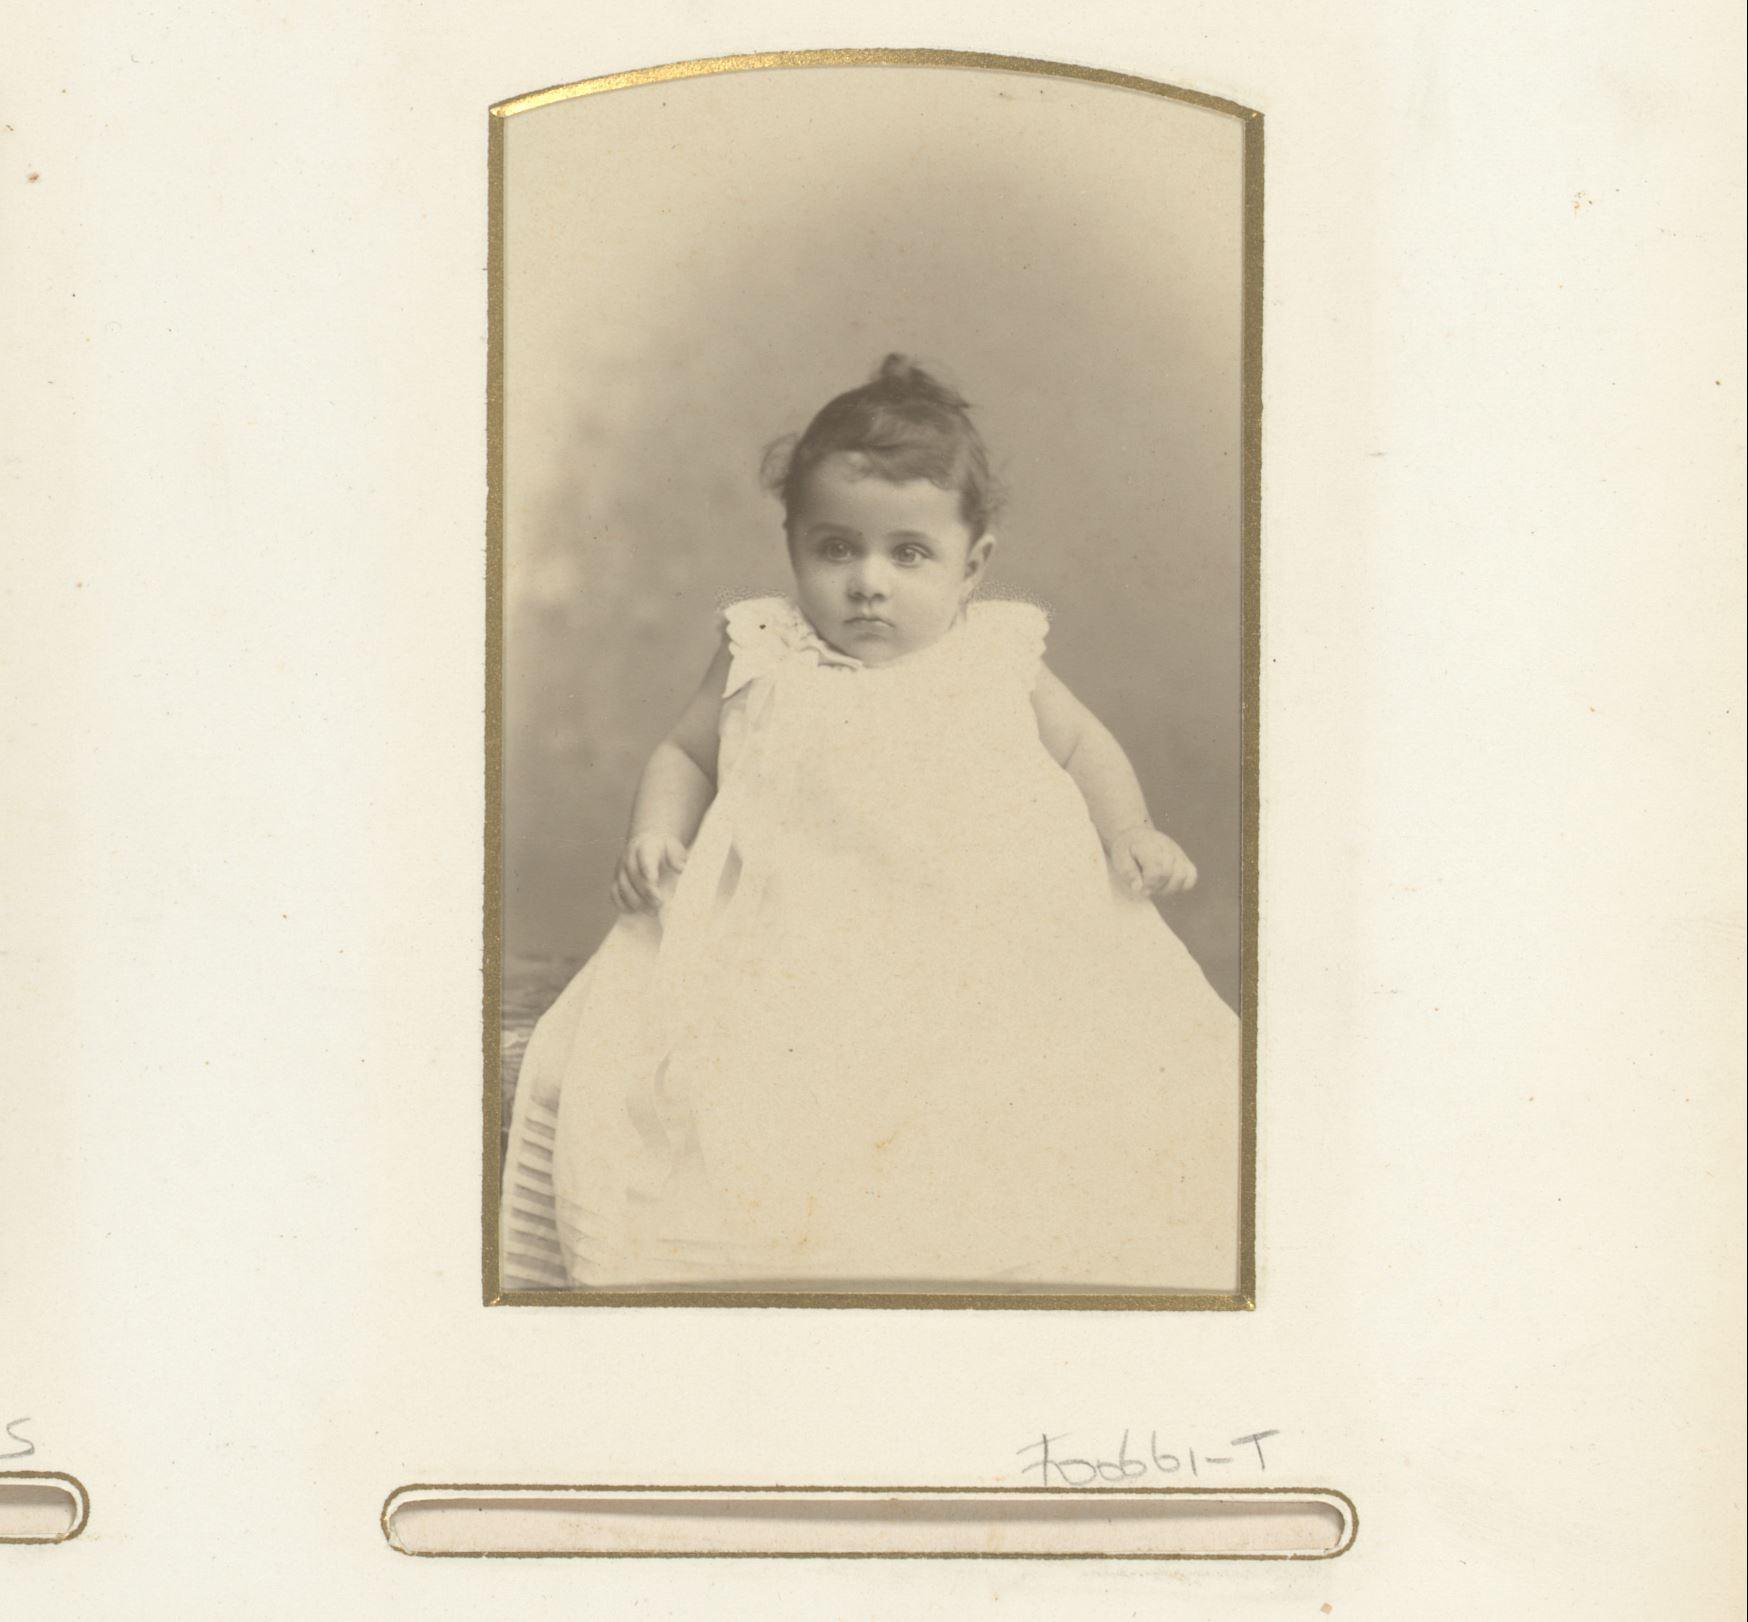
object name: album leaf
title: Portret van een baby in doopjurk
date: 1895-1940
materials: cardboard, photographic support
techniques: matte daylight collodion silver print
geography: batavia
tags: historical persons - bb - woman, baptism, christening gown, infant, baby ~ the ages of man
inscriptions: inscription: ‘Charls & van Es & Co’